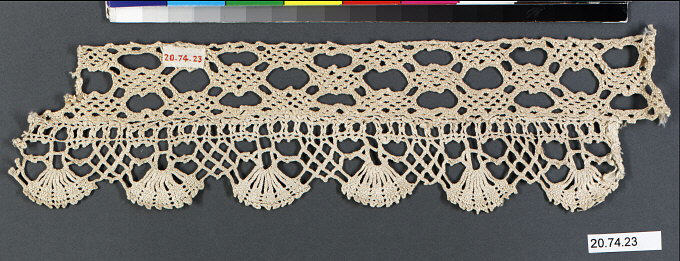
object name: fragment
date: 1501-1700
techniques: lace